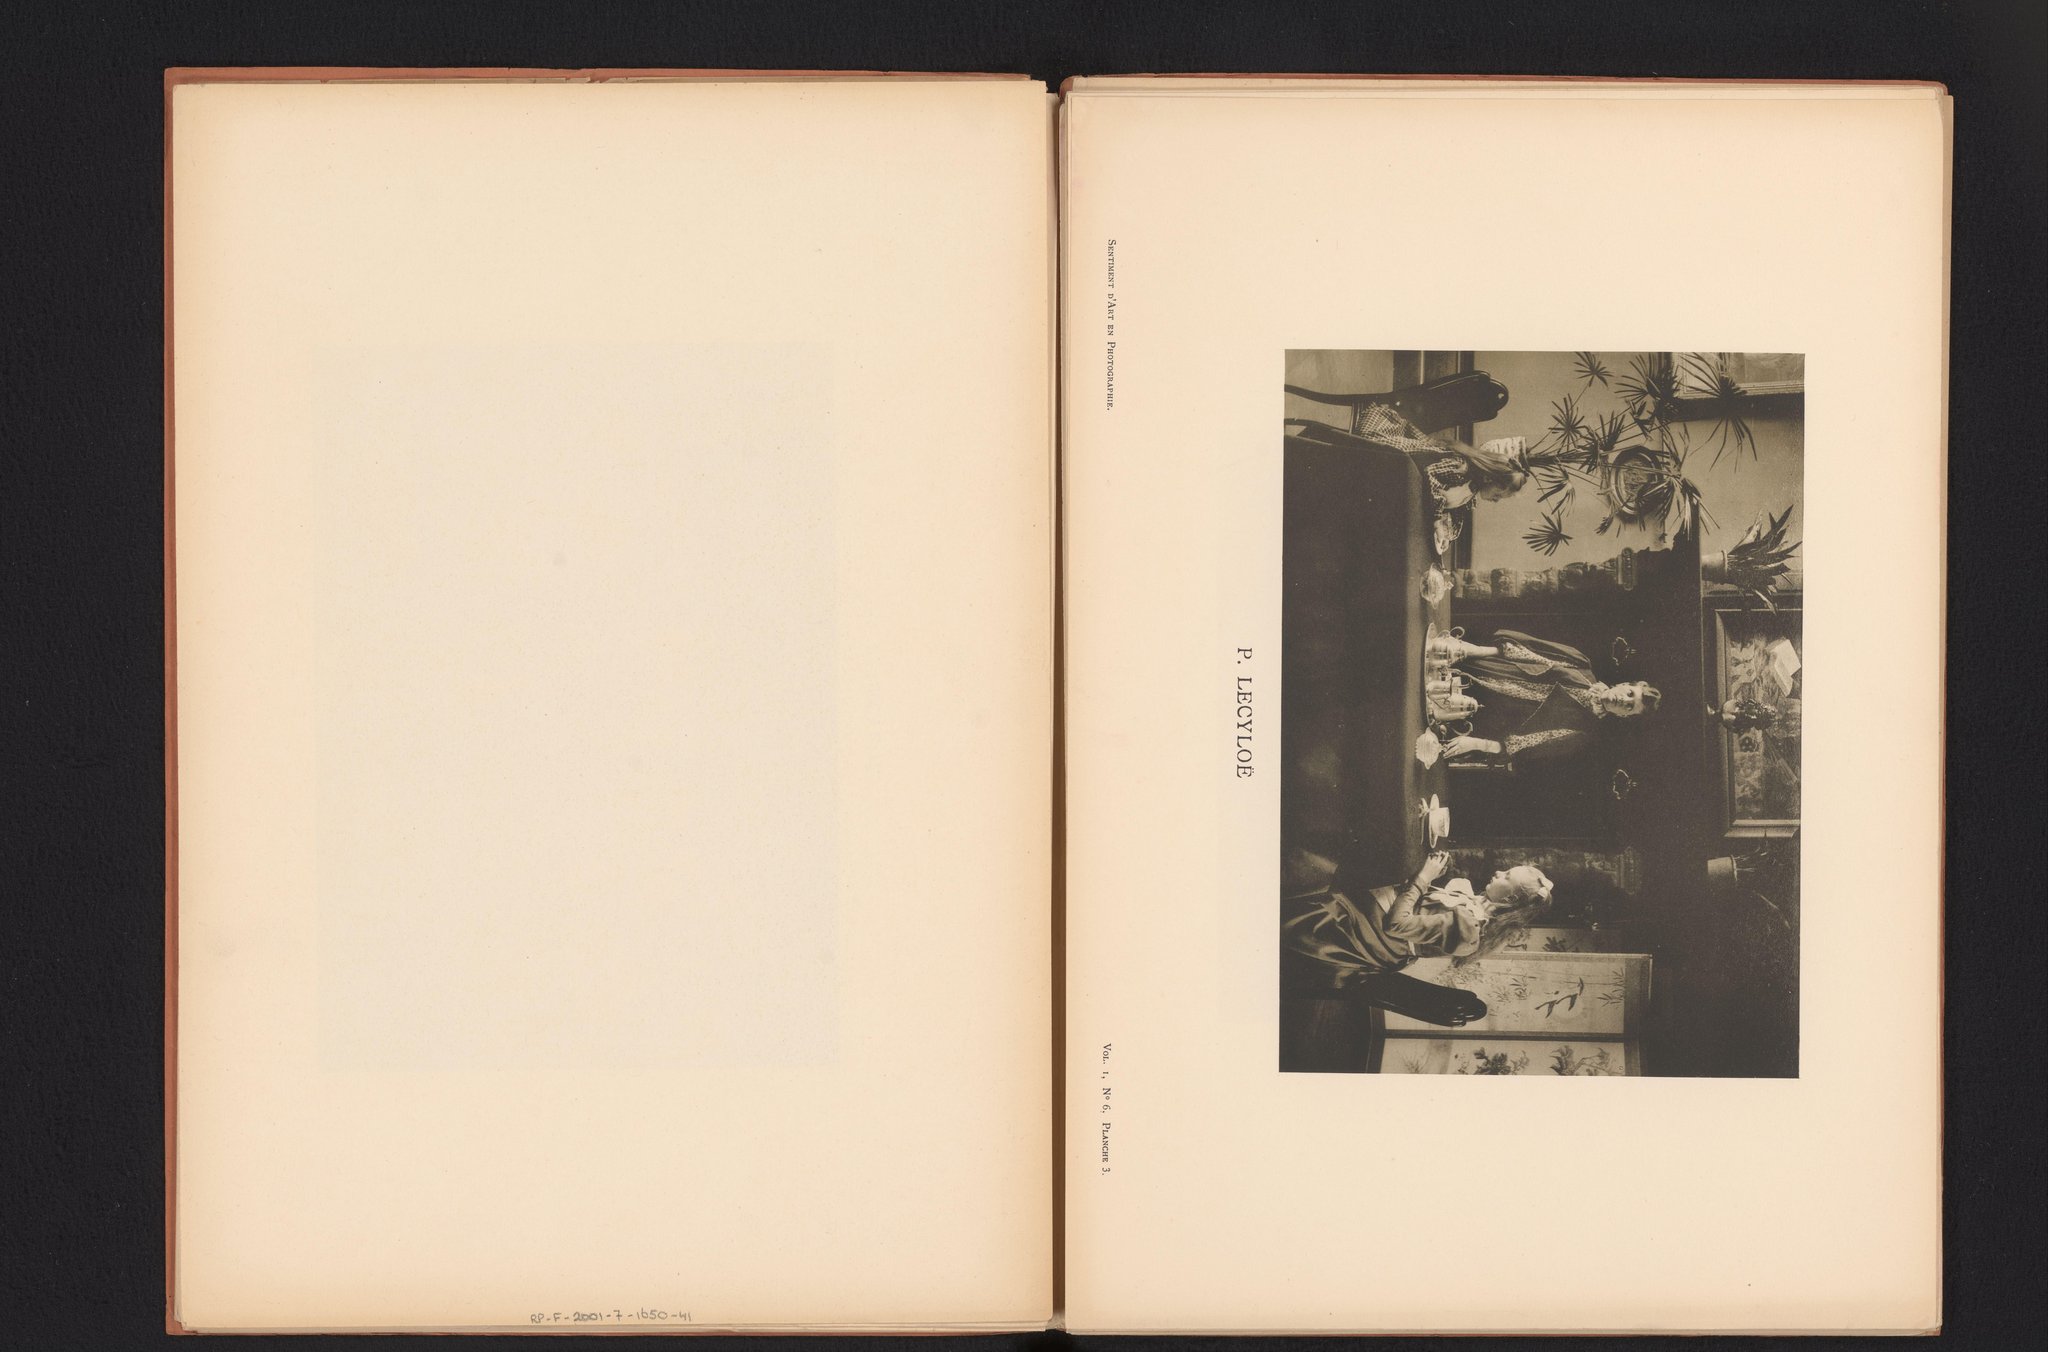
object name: photomechanical print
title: Vrouw staat achter een tafel waaraan twee kinderen thee drinken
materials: paper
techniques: photograph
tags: mother and child(ren), woman and child(ren) (family group), cup of tea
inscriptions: number: ‘Vol. 1, No 6, Planche 3.’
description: Deze prent maakt deel uit van 8 omslagen met 22 tekstbladen en 89 prenten op losse bladen in en tussen de omslagen.